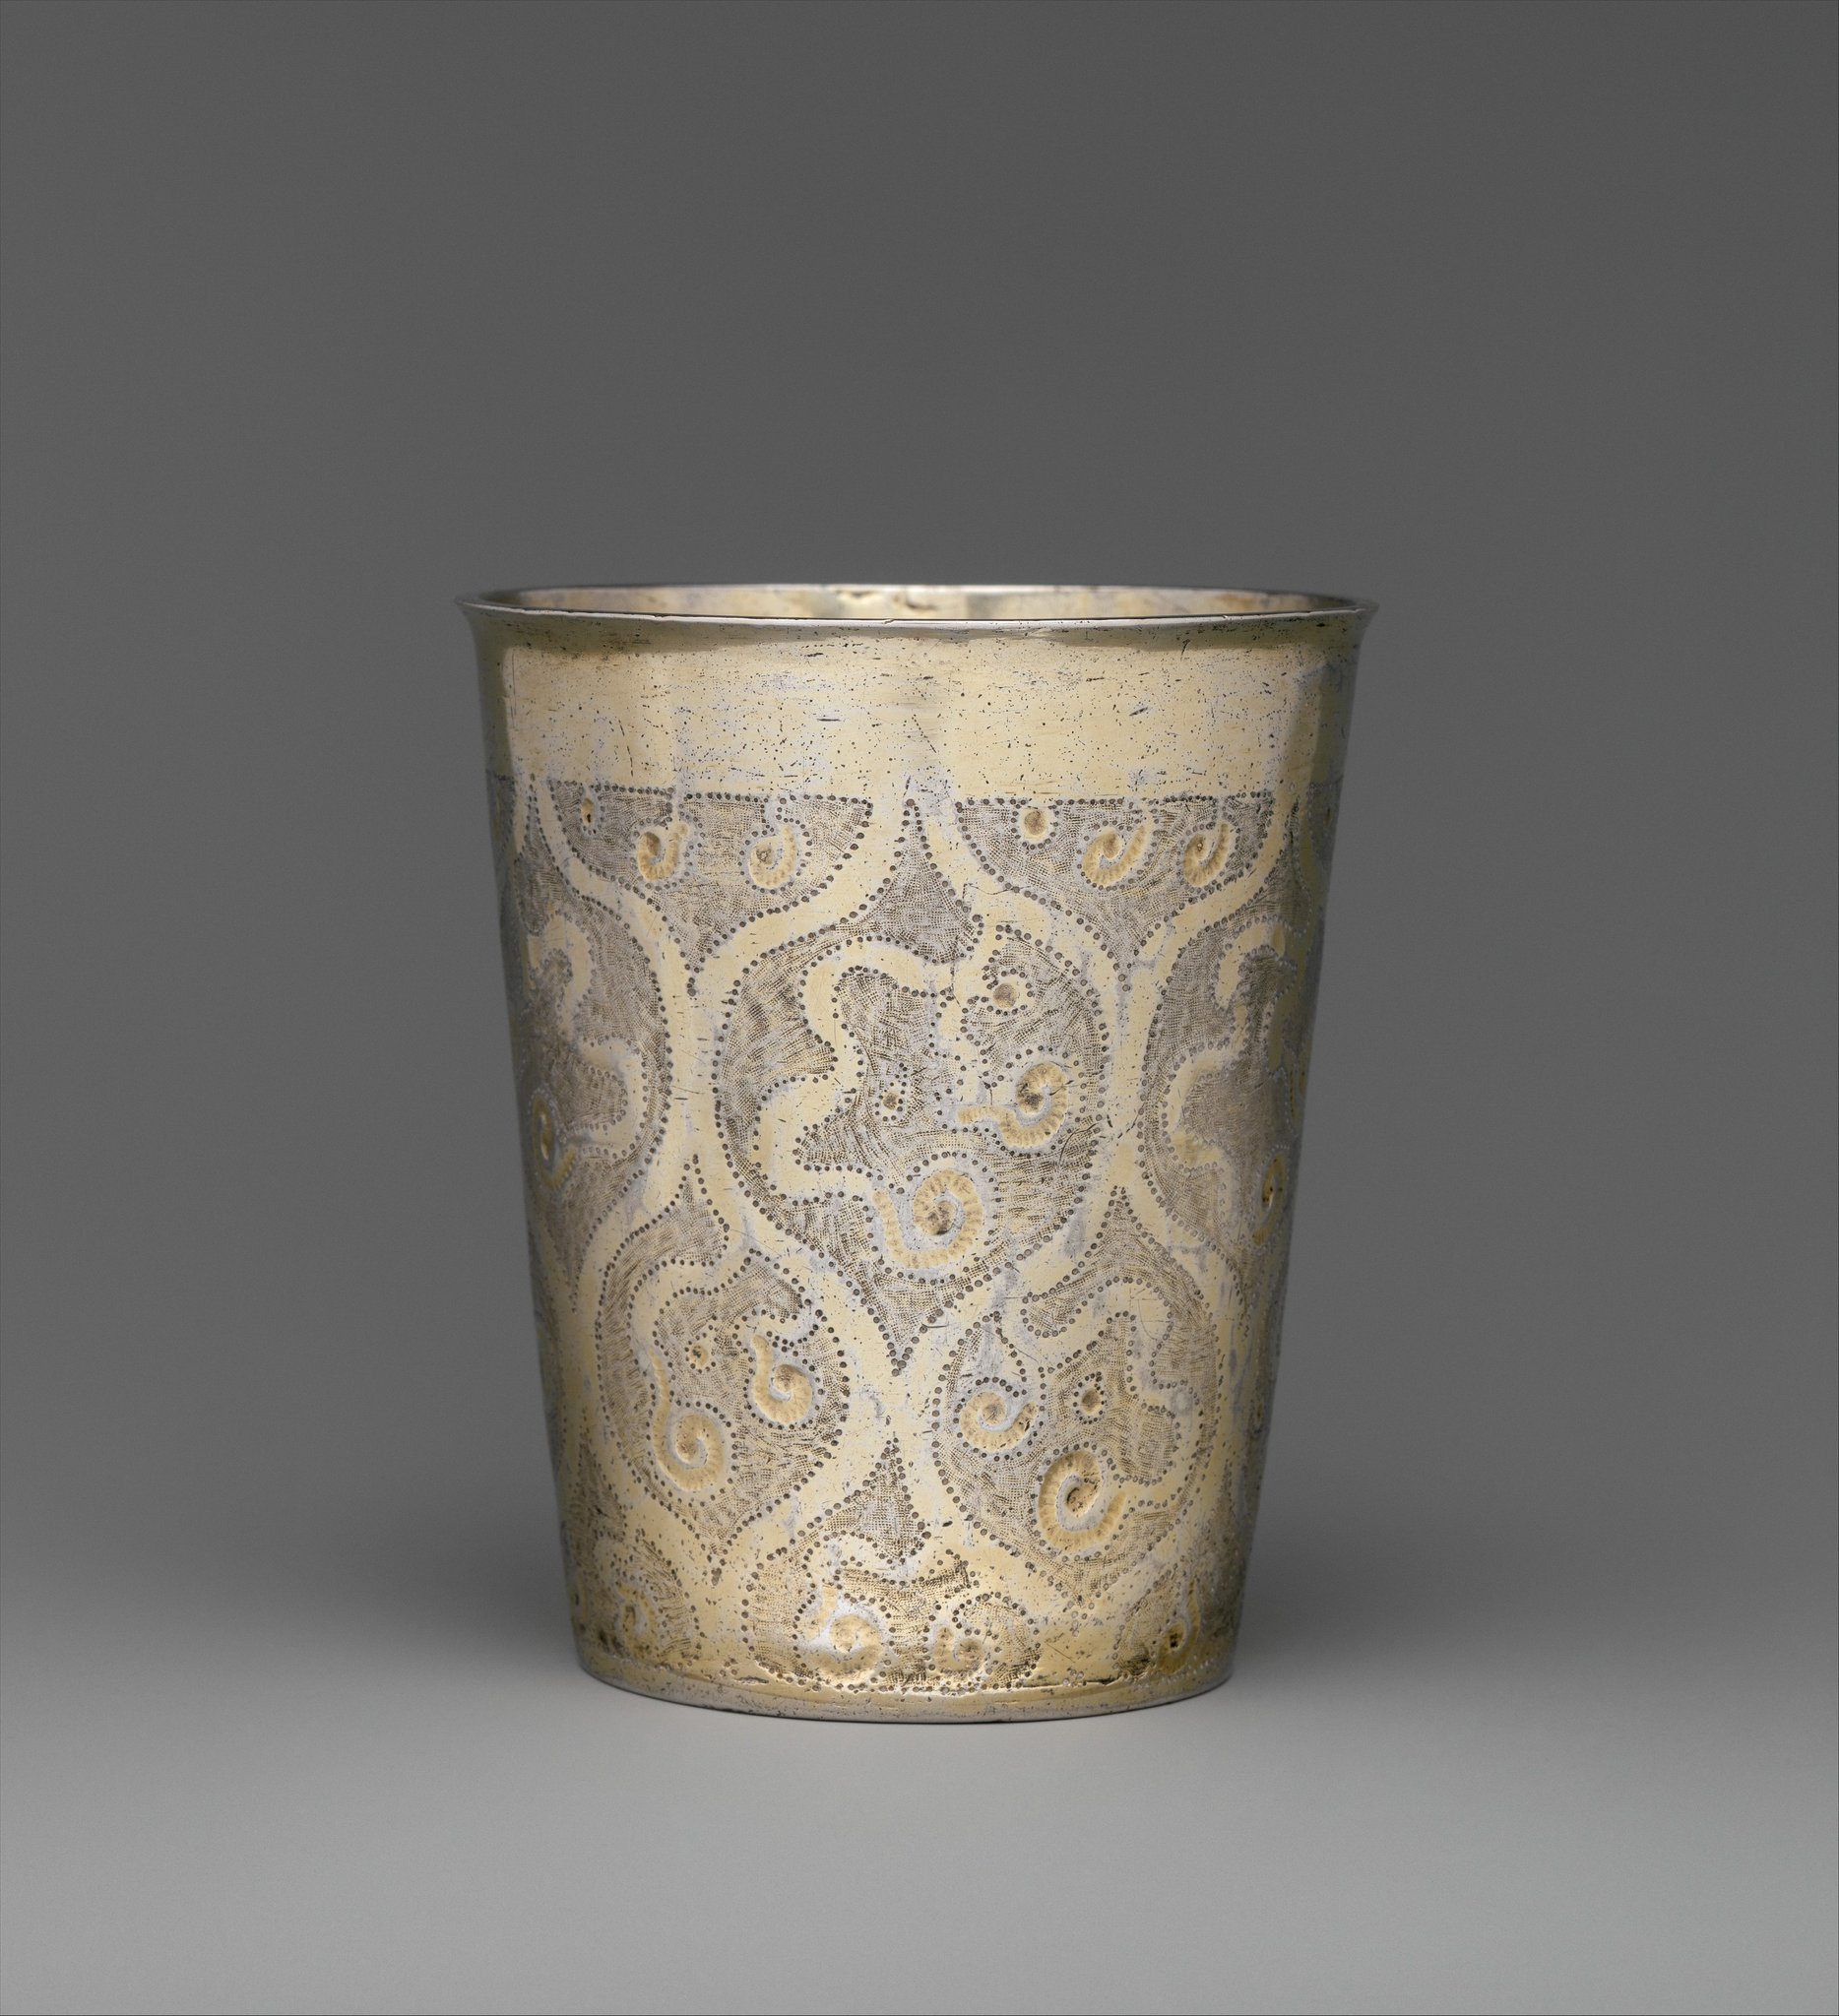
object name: beaker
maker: matthäus bair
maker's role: maker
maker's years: 1550-1626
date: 1567-1600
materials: gilt silver